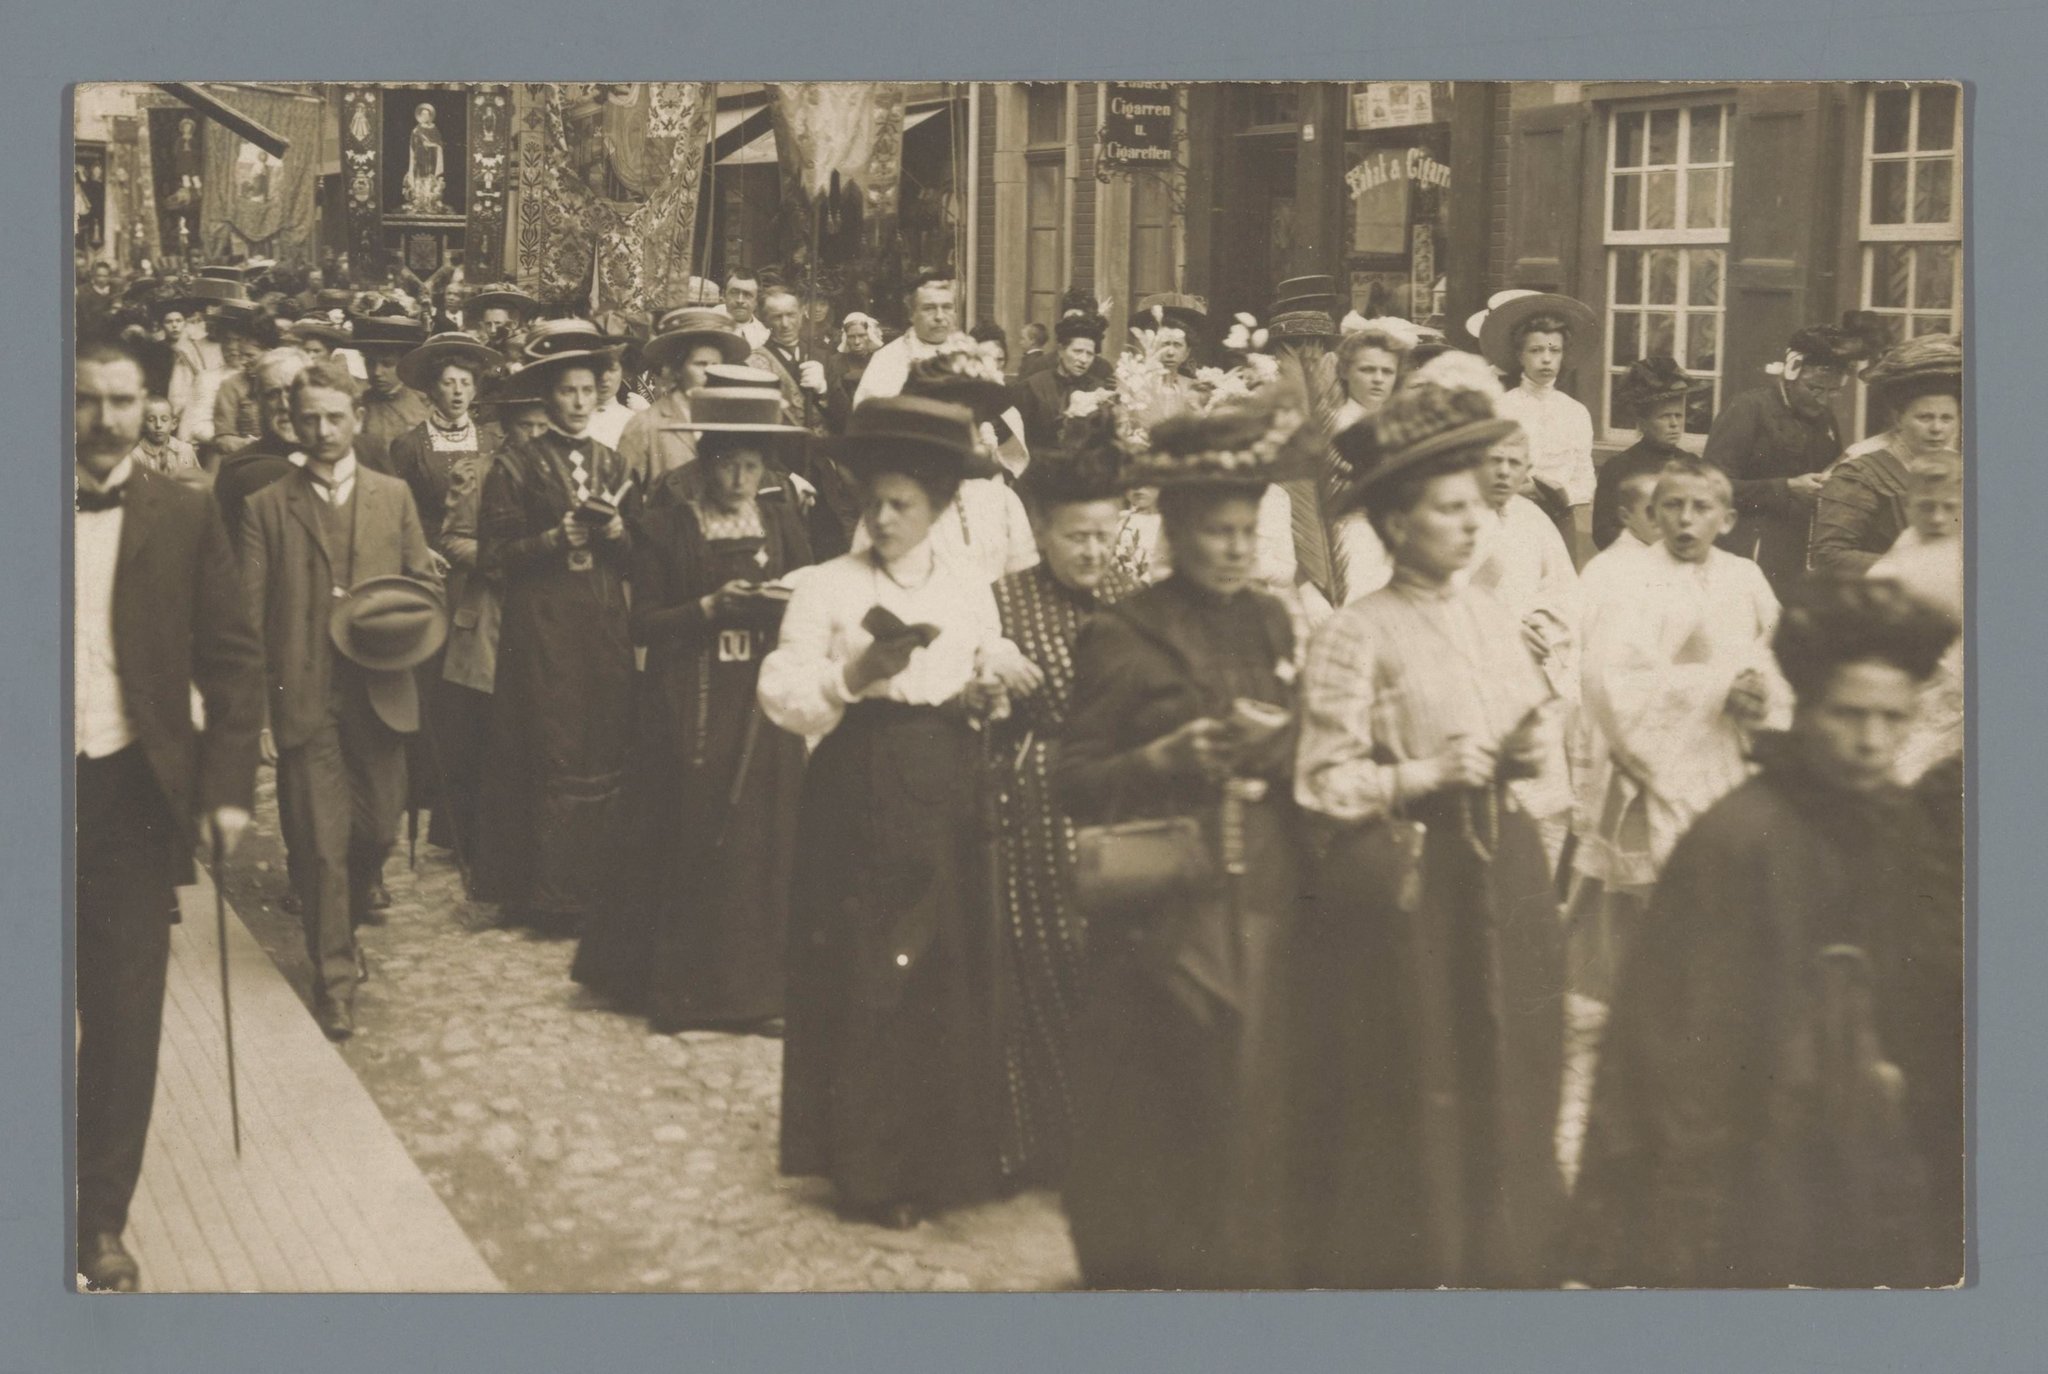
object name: ansichtkaart, prentbriefkaart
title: Katholieke processie te Kevelaer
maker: hubert koch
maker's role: fotograaf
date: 1907-1915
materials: photographic support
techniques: gelatin silver print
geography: kevelaer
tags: procession ~ christian religion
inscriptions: inscription: ‘Hubert Koch, Kevelaer.’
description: RP-F-F20751 is op dezelfde plek genomen.